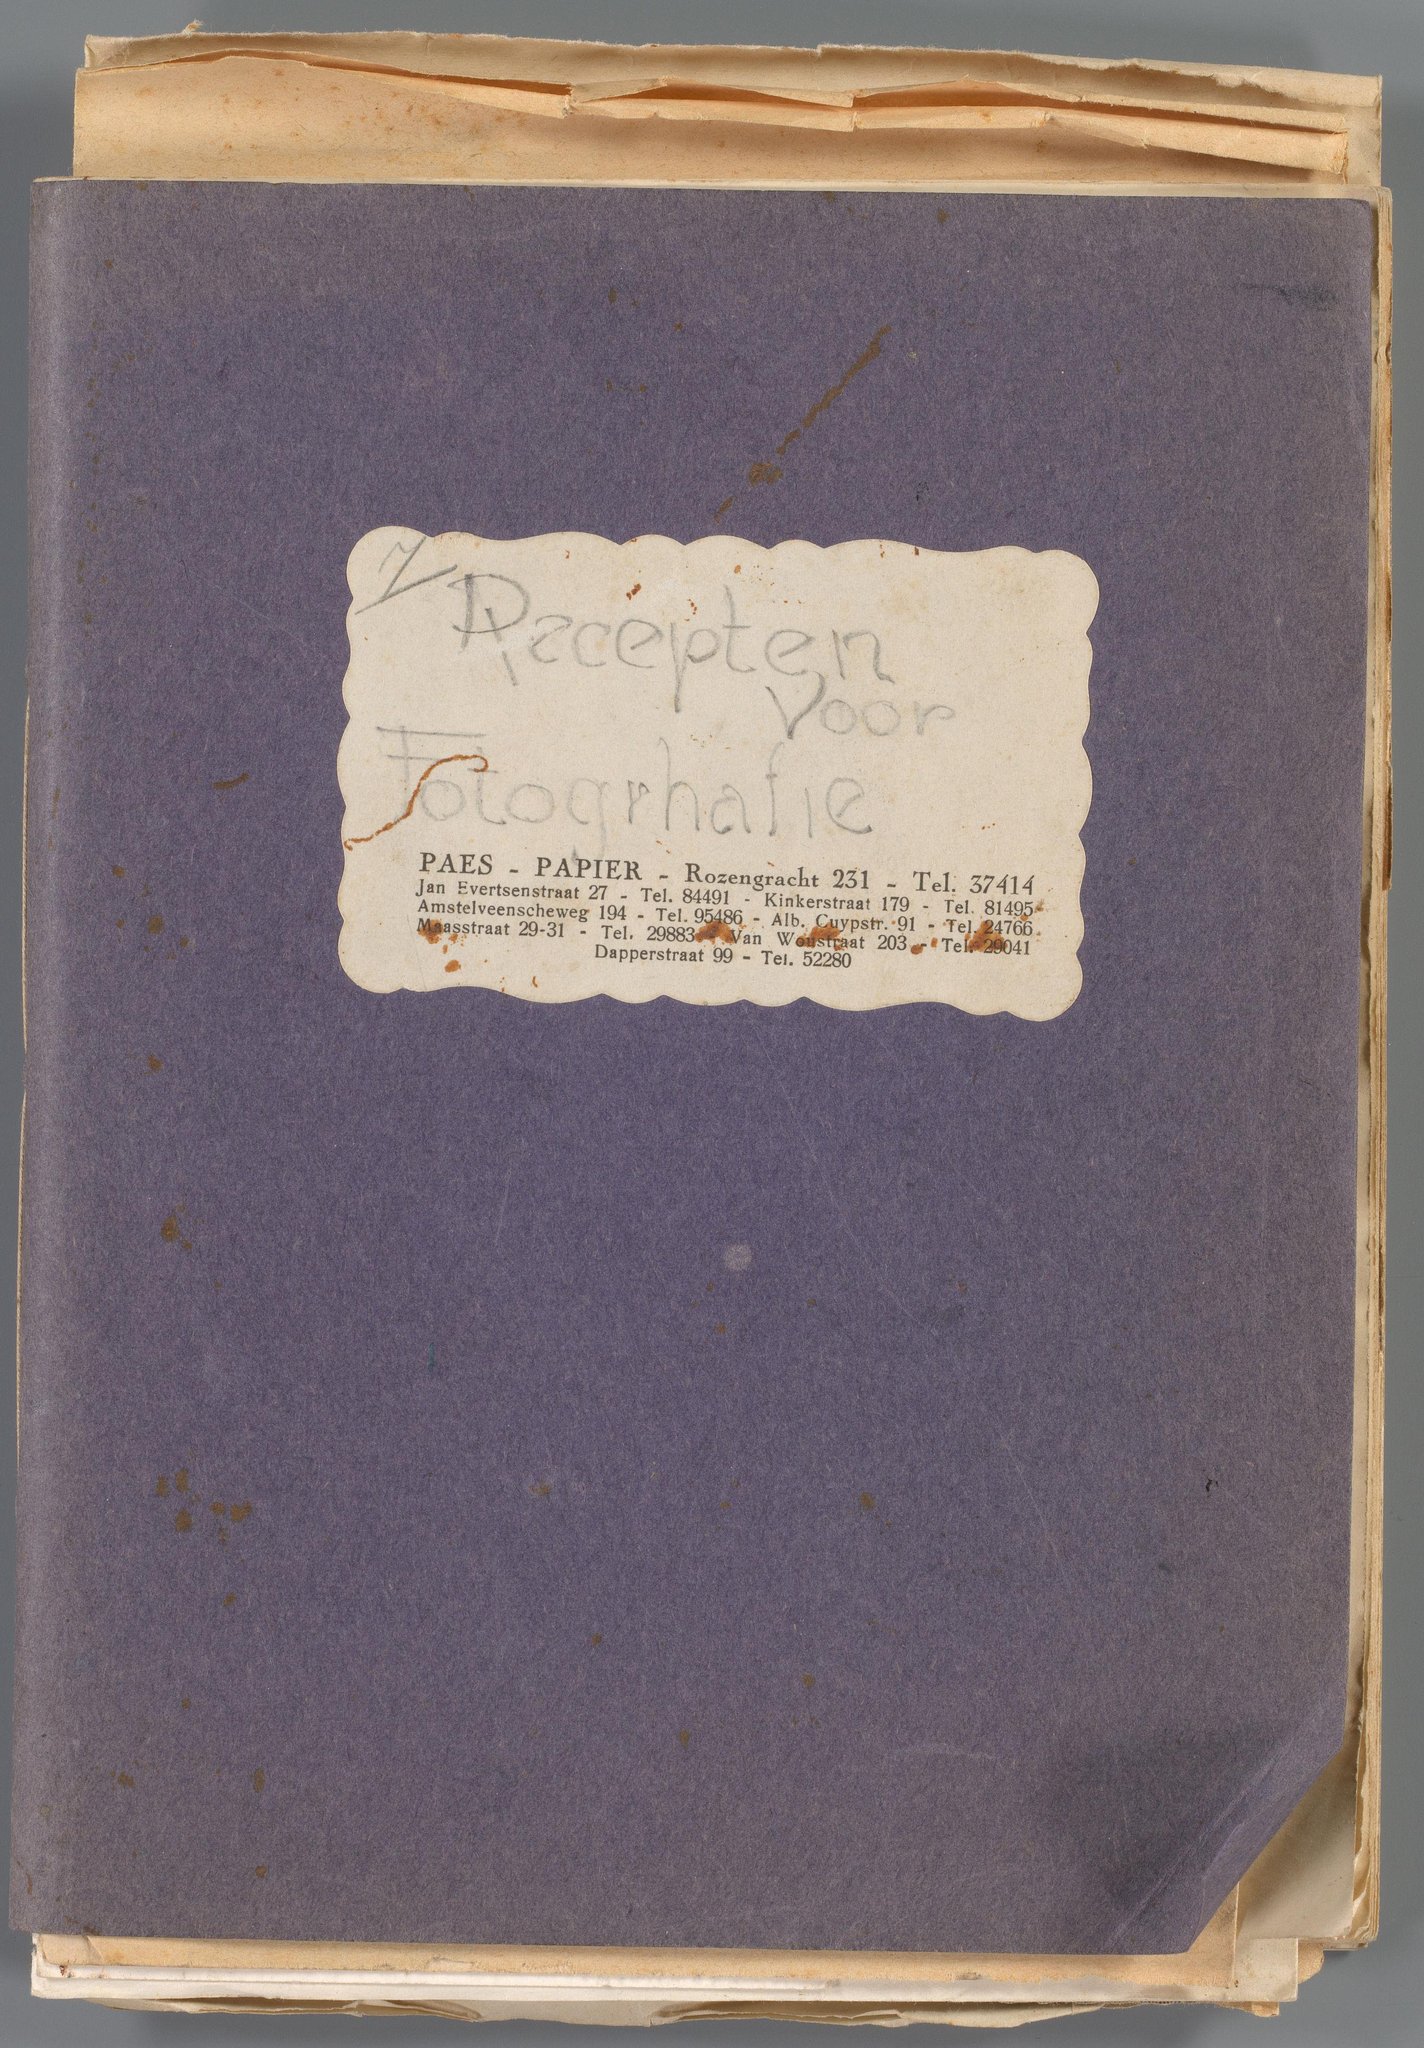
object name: exercise book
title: Recepten voor fotografie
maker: jan petrus ponstijn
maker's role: draughtsman, print maker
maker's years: 1883-1970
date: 1903-1970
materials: cardboard, ink, cordage, paper, pencil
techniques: pen, printing, typewriting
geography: amsterdam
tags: plate, film ~ photography, processing film, photographer at work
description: Aantekeningenschrift, mogelijk samengesteld door Jan Ponstijn, met deels ingeplakte krantenknipsels gericht op amateurfotografen over ontwikkelaars, fotograferen en ontwikkelen bij diverse weersomstandigheden, gebruik en bewaren van chemicaliën, aanwijzingen voor het belichten en vergroten, chemische hulpmiddelen bij problemen met negatieven en een introductie op het maken van lantaarnplaatjes. Verder bevat het schrift losse bladen met aantekeningen aangaande de opname- en ontwikkelomstandigheden van bepaalde foto's, een belichtstabel voor Gevaert films, een gebruiksaanwijzing voor Agfa Rodinel ontwikkelaar, een informatiefolder voor Criterion platen, een gebruiksaanwijzing voor Höfinghoff gaslichtpapier en een verpakkingsflap van Agfa Isochrom film. Tenslotte bevat het schrift uitgetypte recepten.